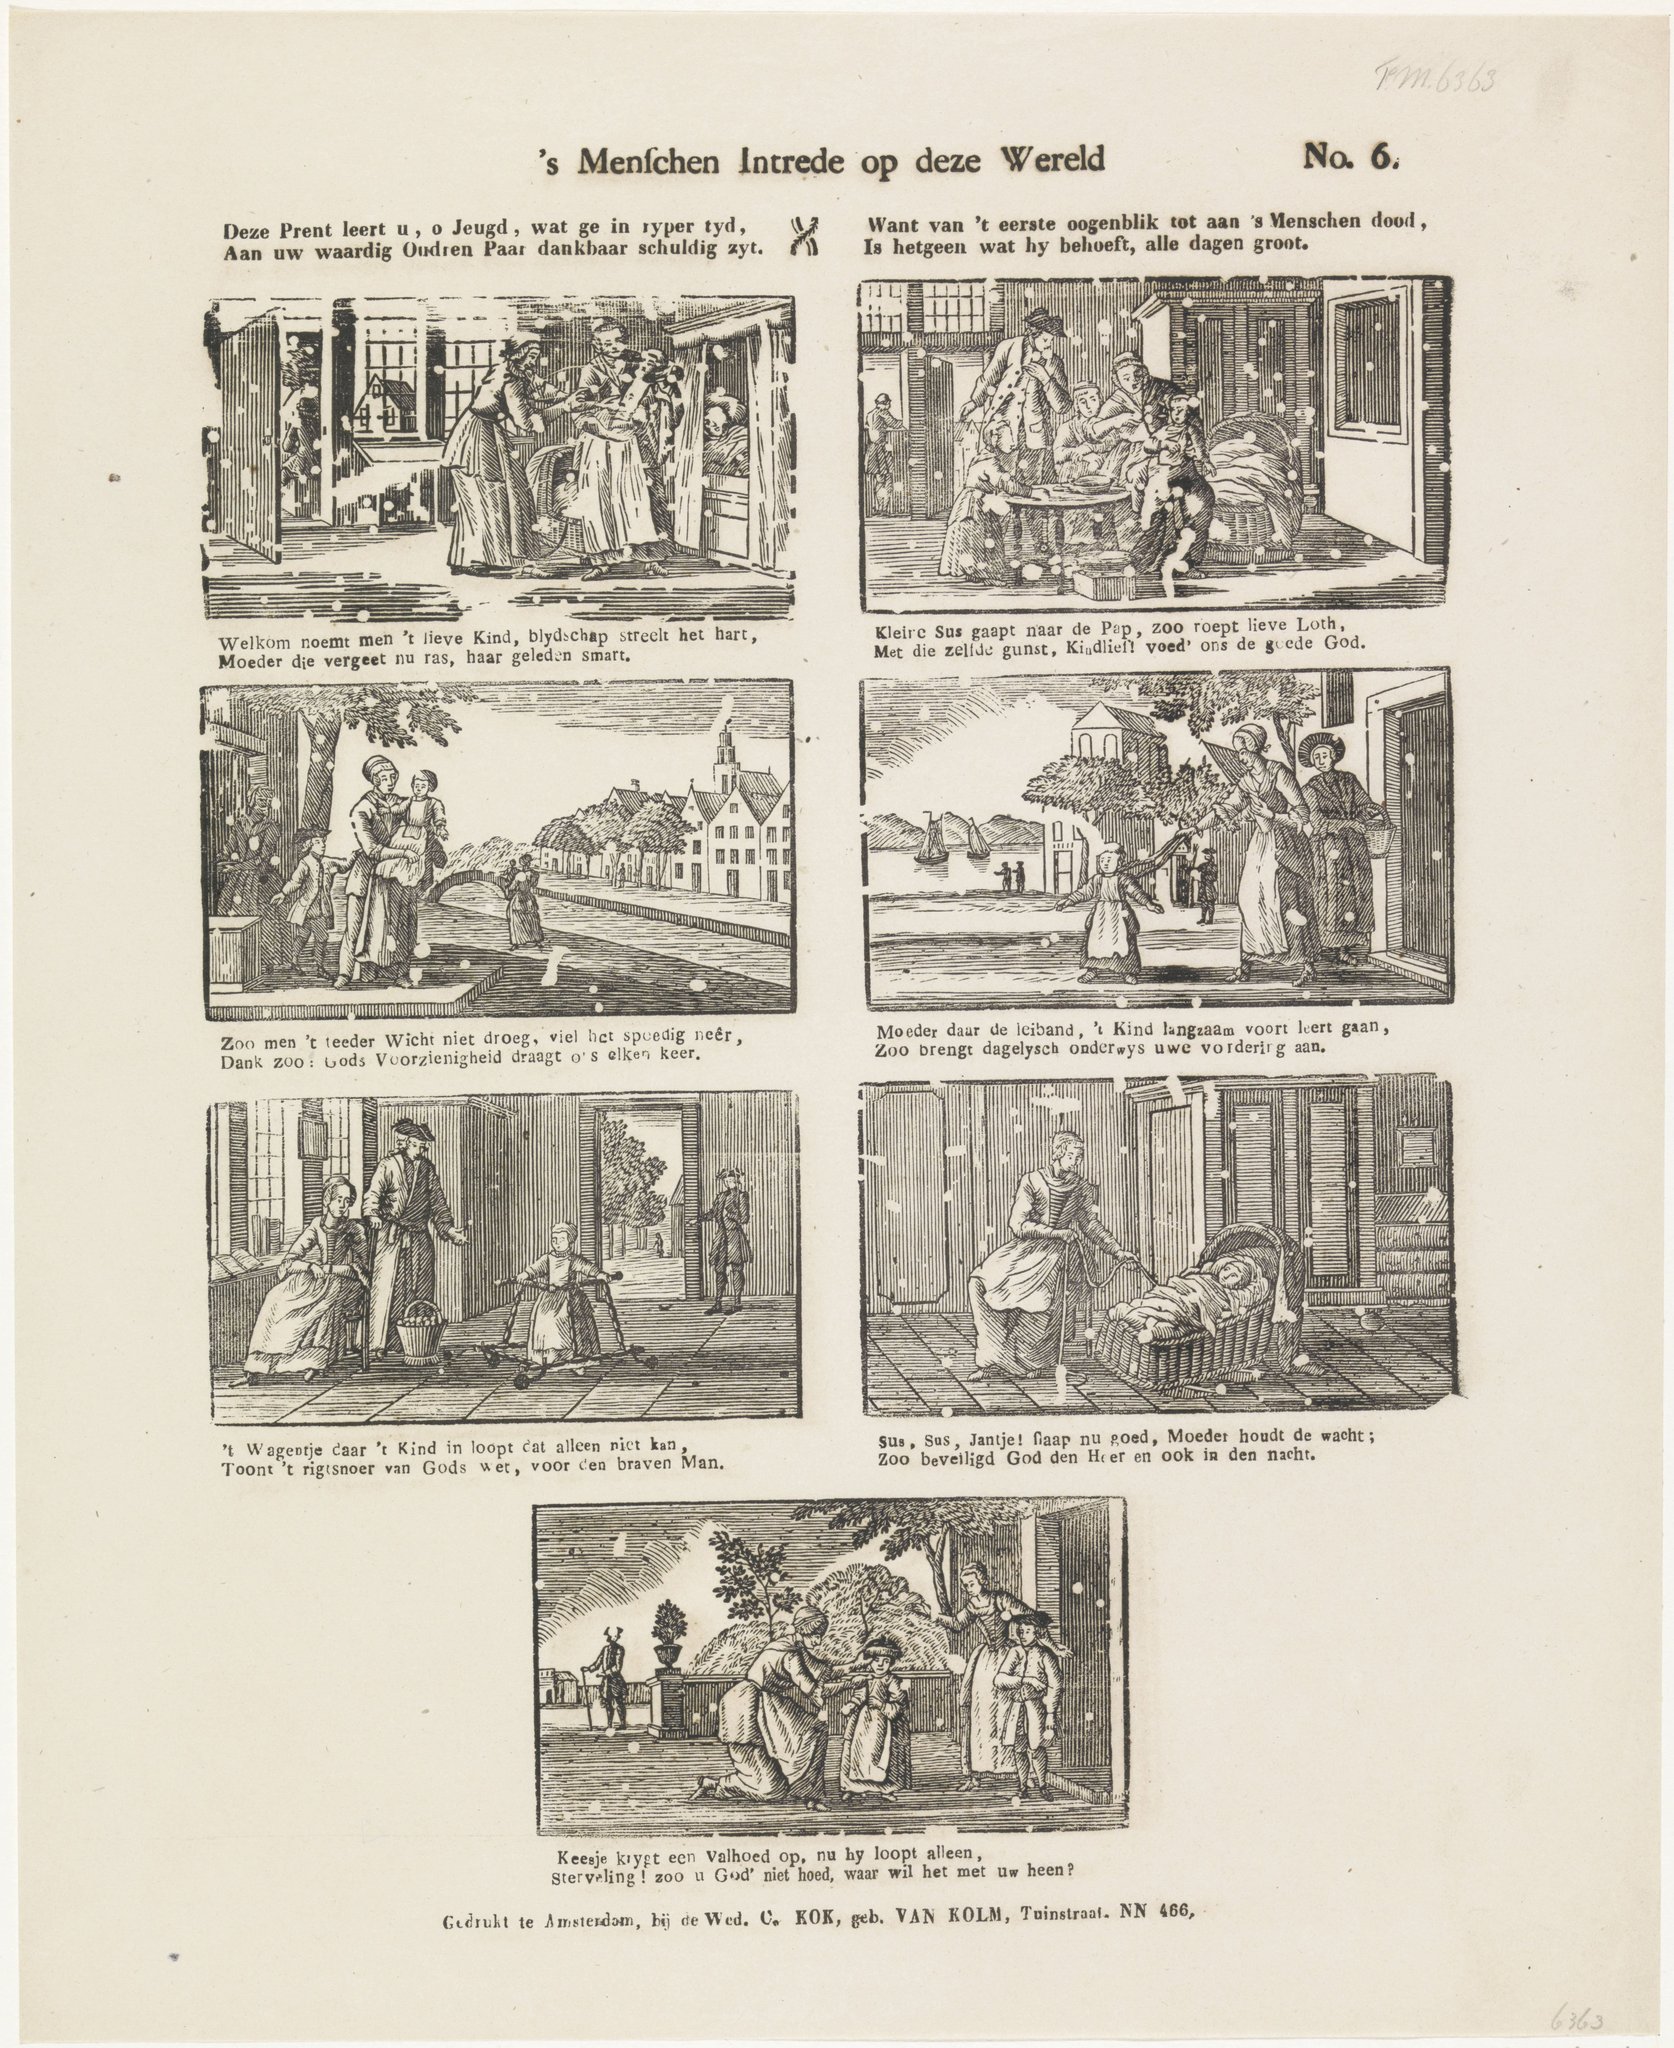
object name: popular print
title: 's Menschen Intrede op deze Wereld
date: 1800-1850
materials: paper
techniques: letterpress printing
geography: netherlands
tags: confinement, birth, growing up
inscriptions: collector's mark: Lugt 2228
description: Blad met zeven voorstellingen van de kindertijd, vanaf geboorte tot leren lopen met een valhoed op. Onder elk plaatje een tweeregelig versje. Ca. 1800-1850. Genummerd rechtsboven: No. 6.